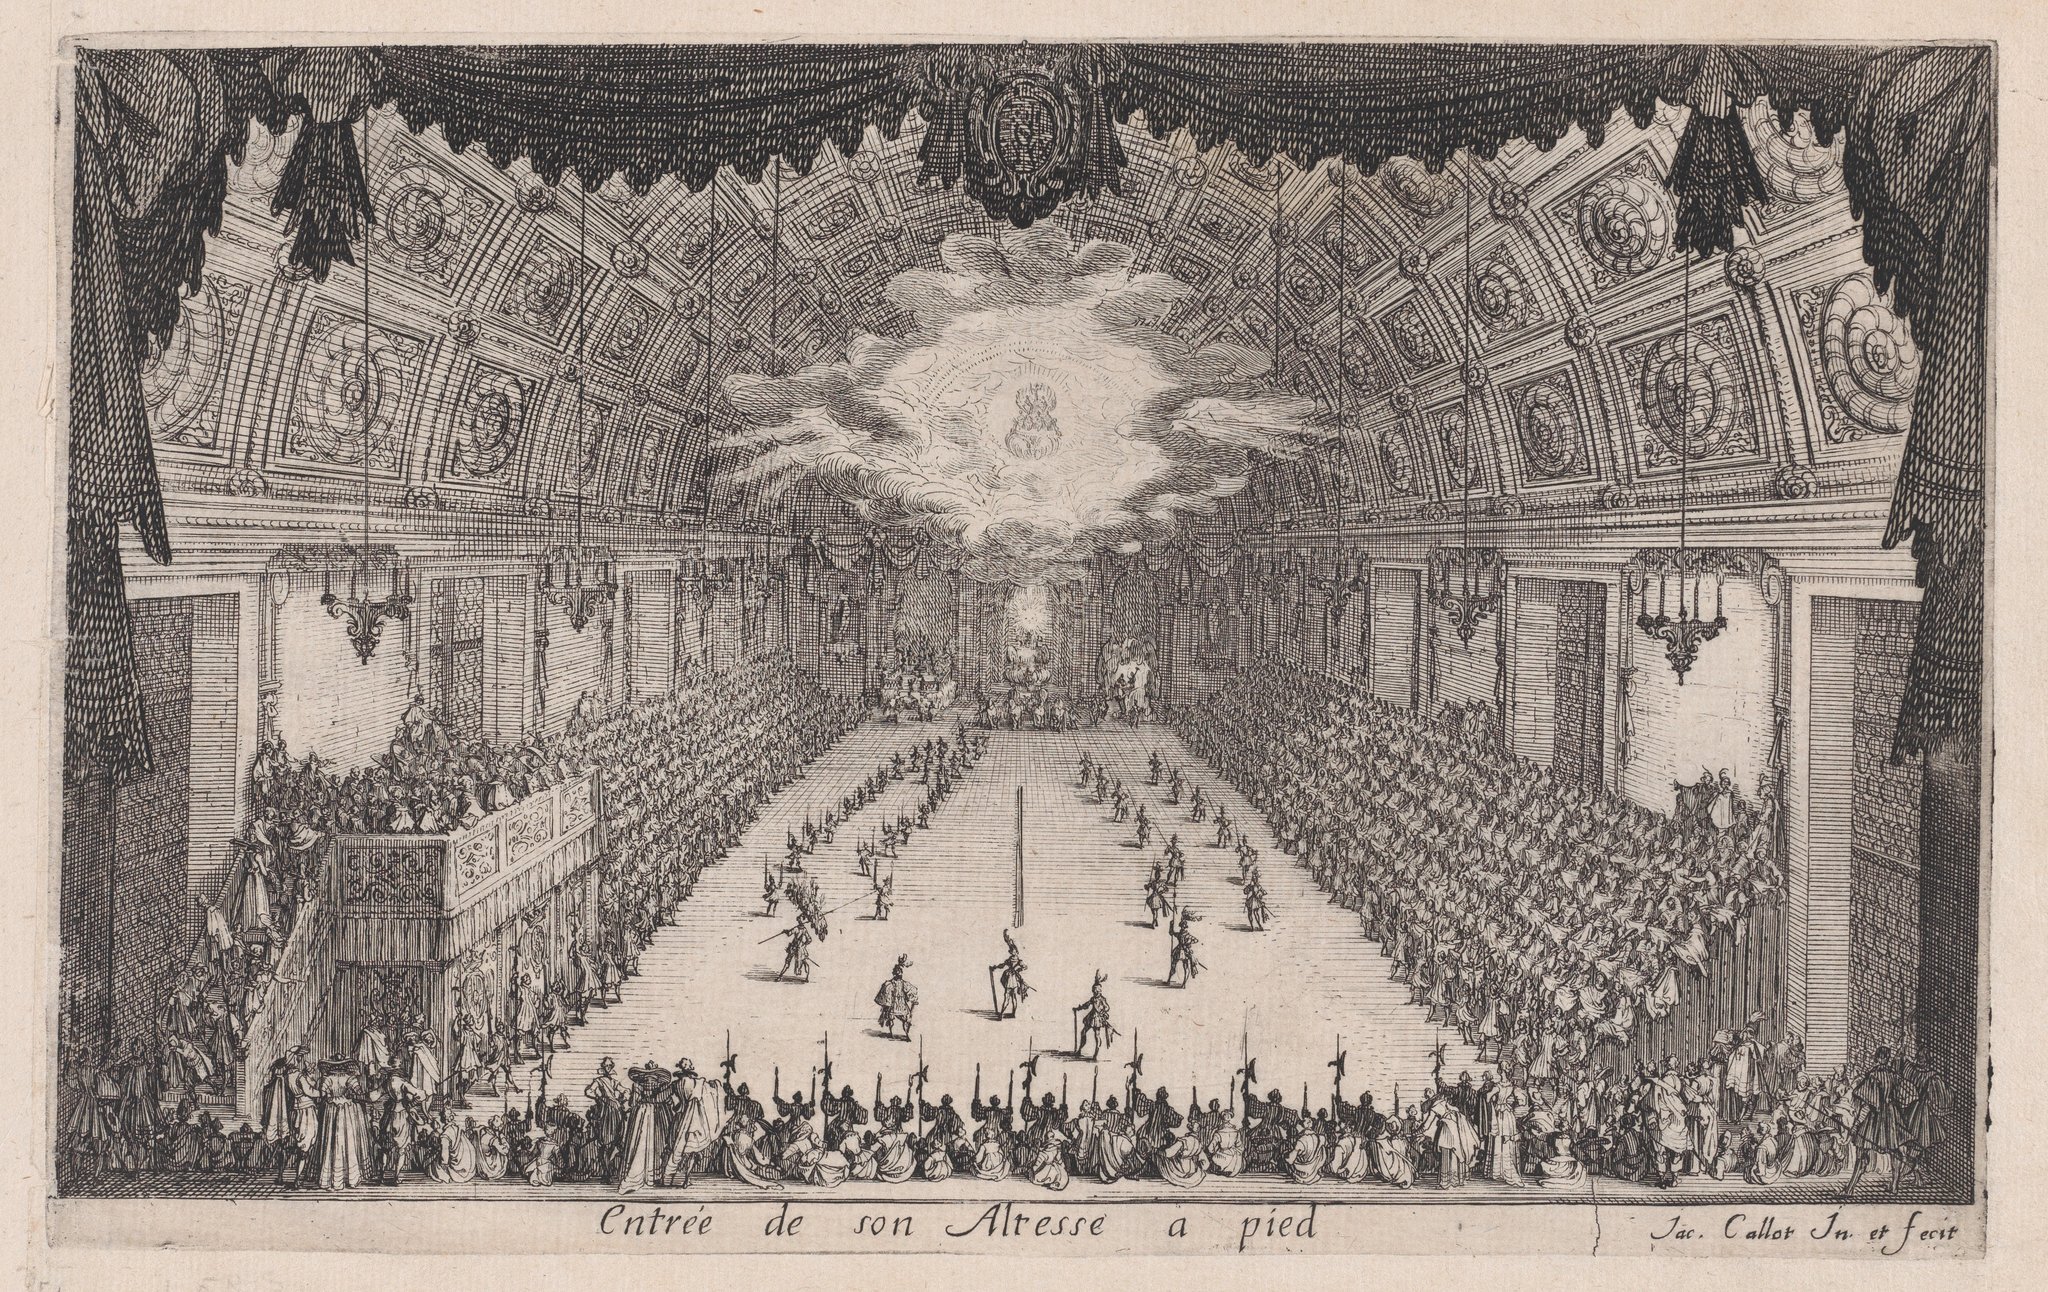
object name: print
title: La Défilé a Pied (The Parade on Foot), from Le Combat a la Barrière in the Palace at Nancy by Henri Humbert, printed by Sebastien Phillipe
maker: jacques callot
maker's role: artist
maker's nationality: french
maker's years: 1592-1635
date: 1627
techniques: etching